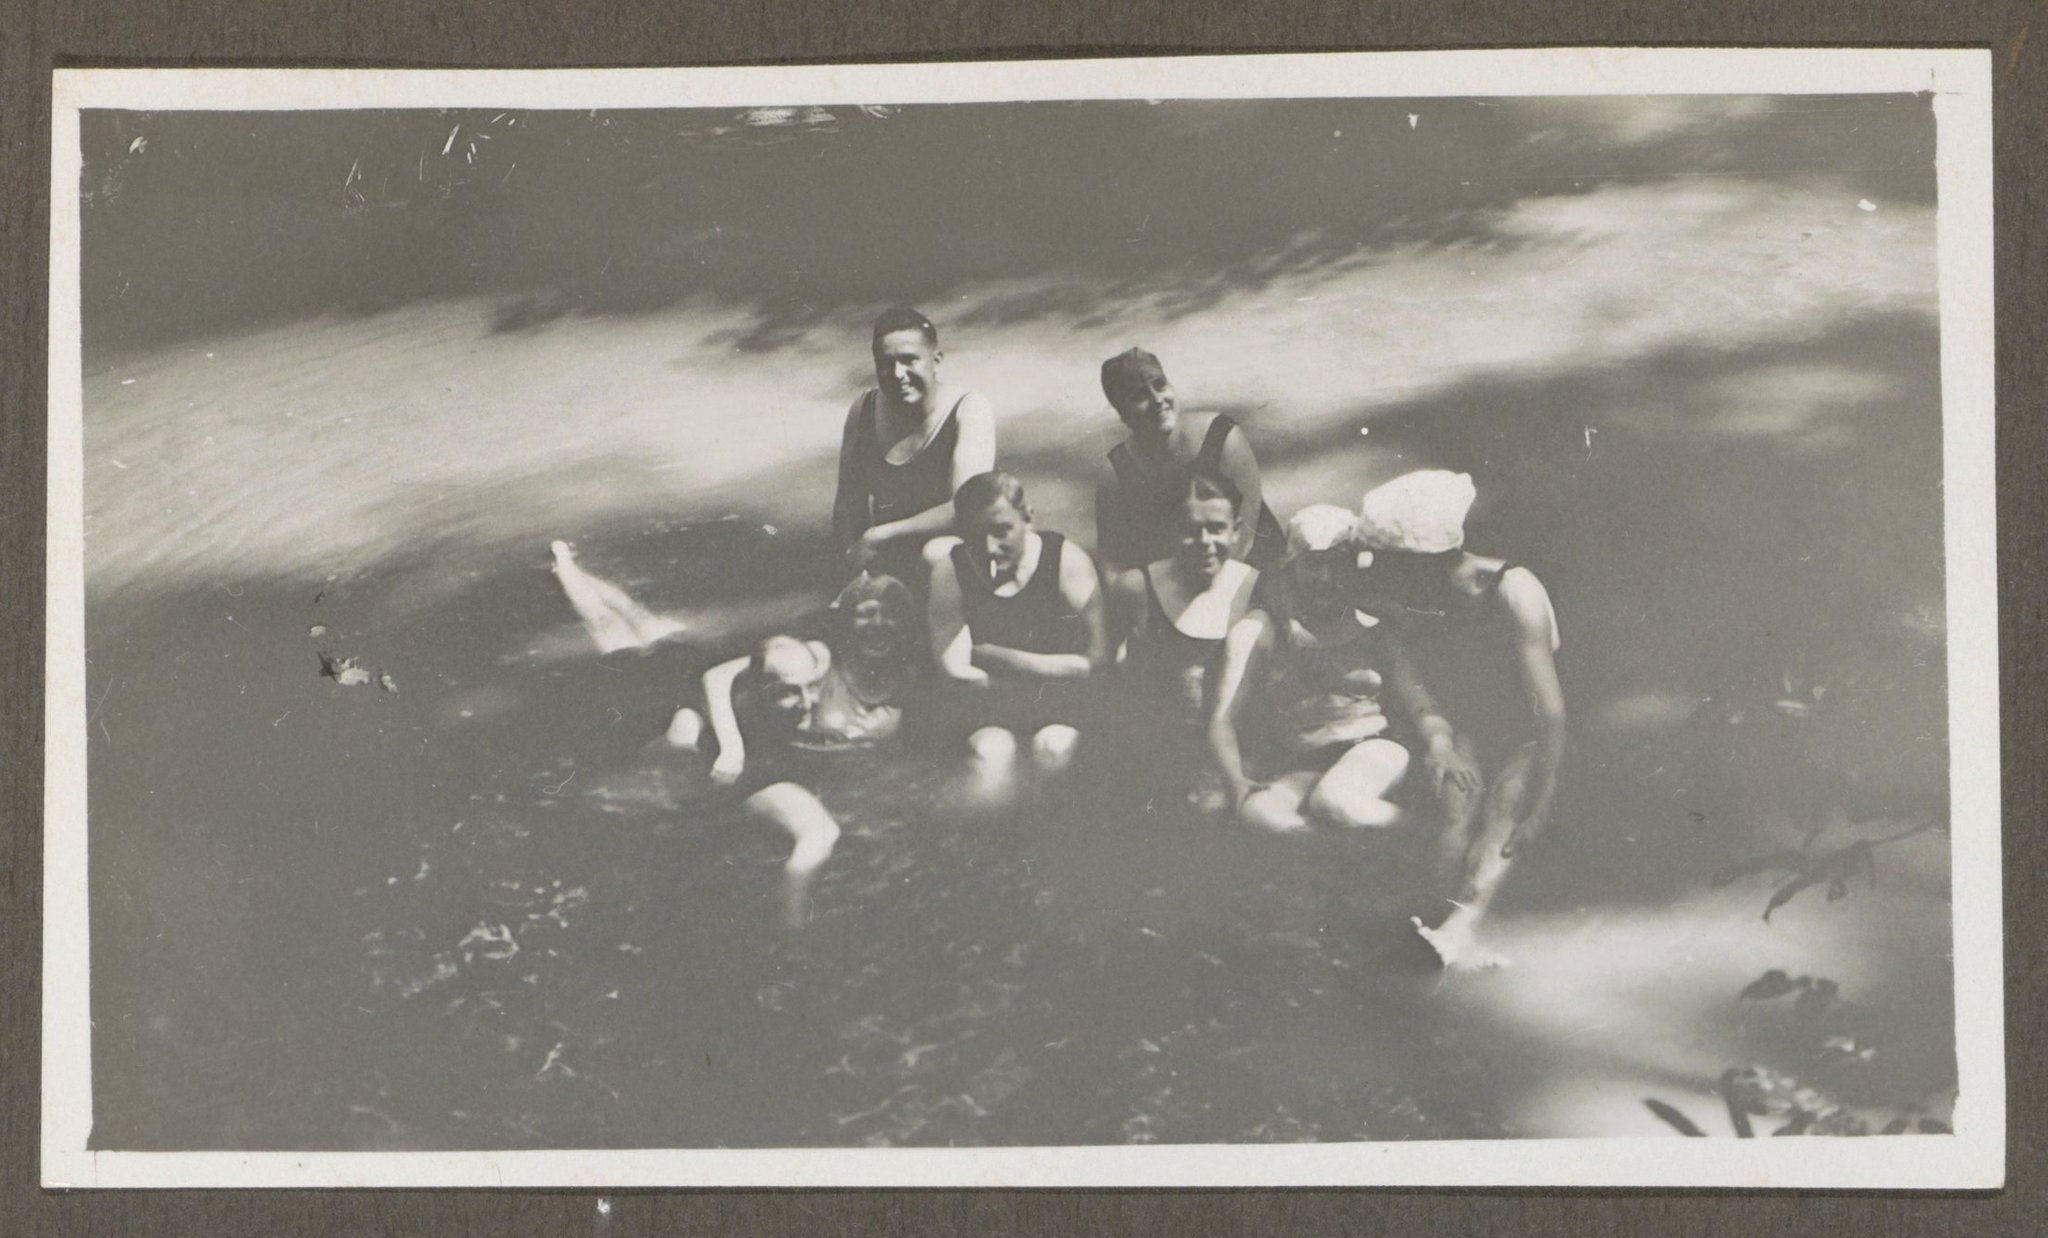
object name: photograph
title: Groep mannen en vrouwen poserend in ondiep water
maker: Anonymous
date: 1920-1930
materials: photographic support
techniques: gelatin silver print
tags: swimming (movement in water) (+ eight persons), dutch east indies, the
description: Onderdeel van familiealbum Nederlands-Indië.